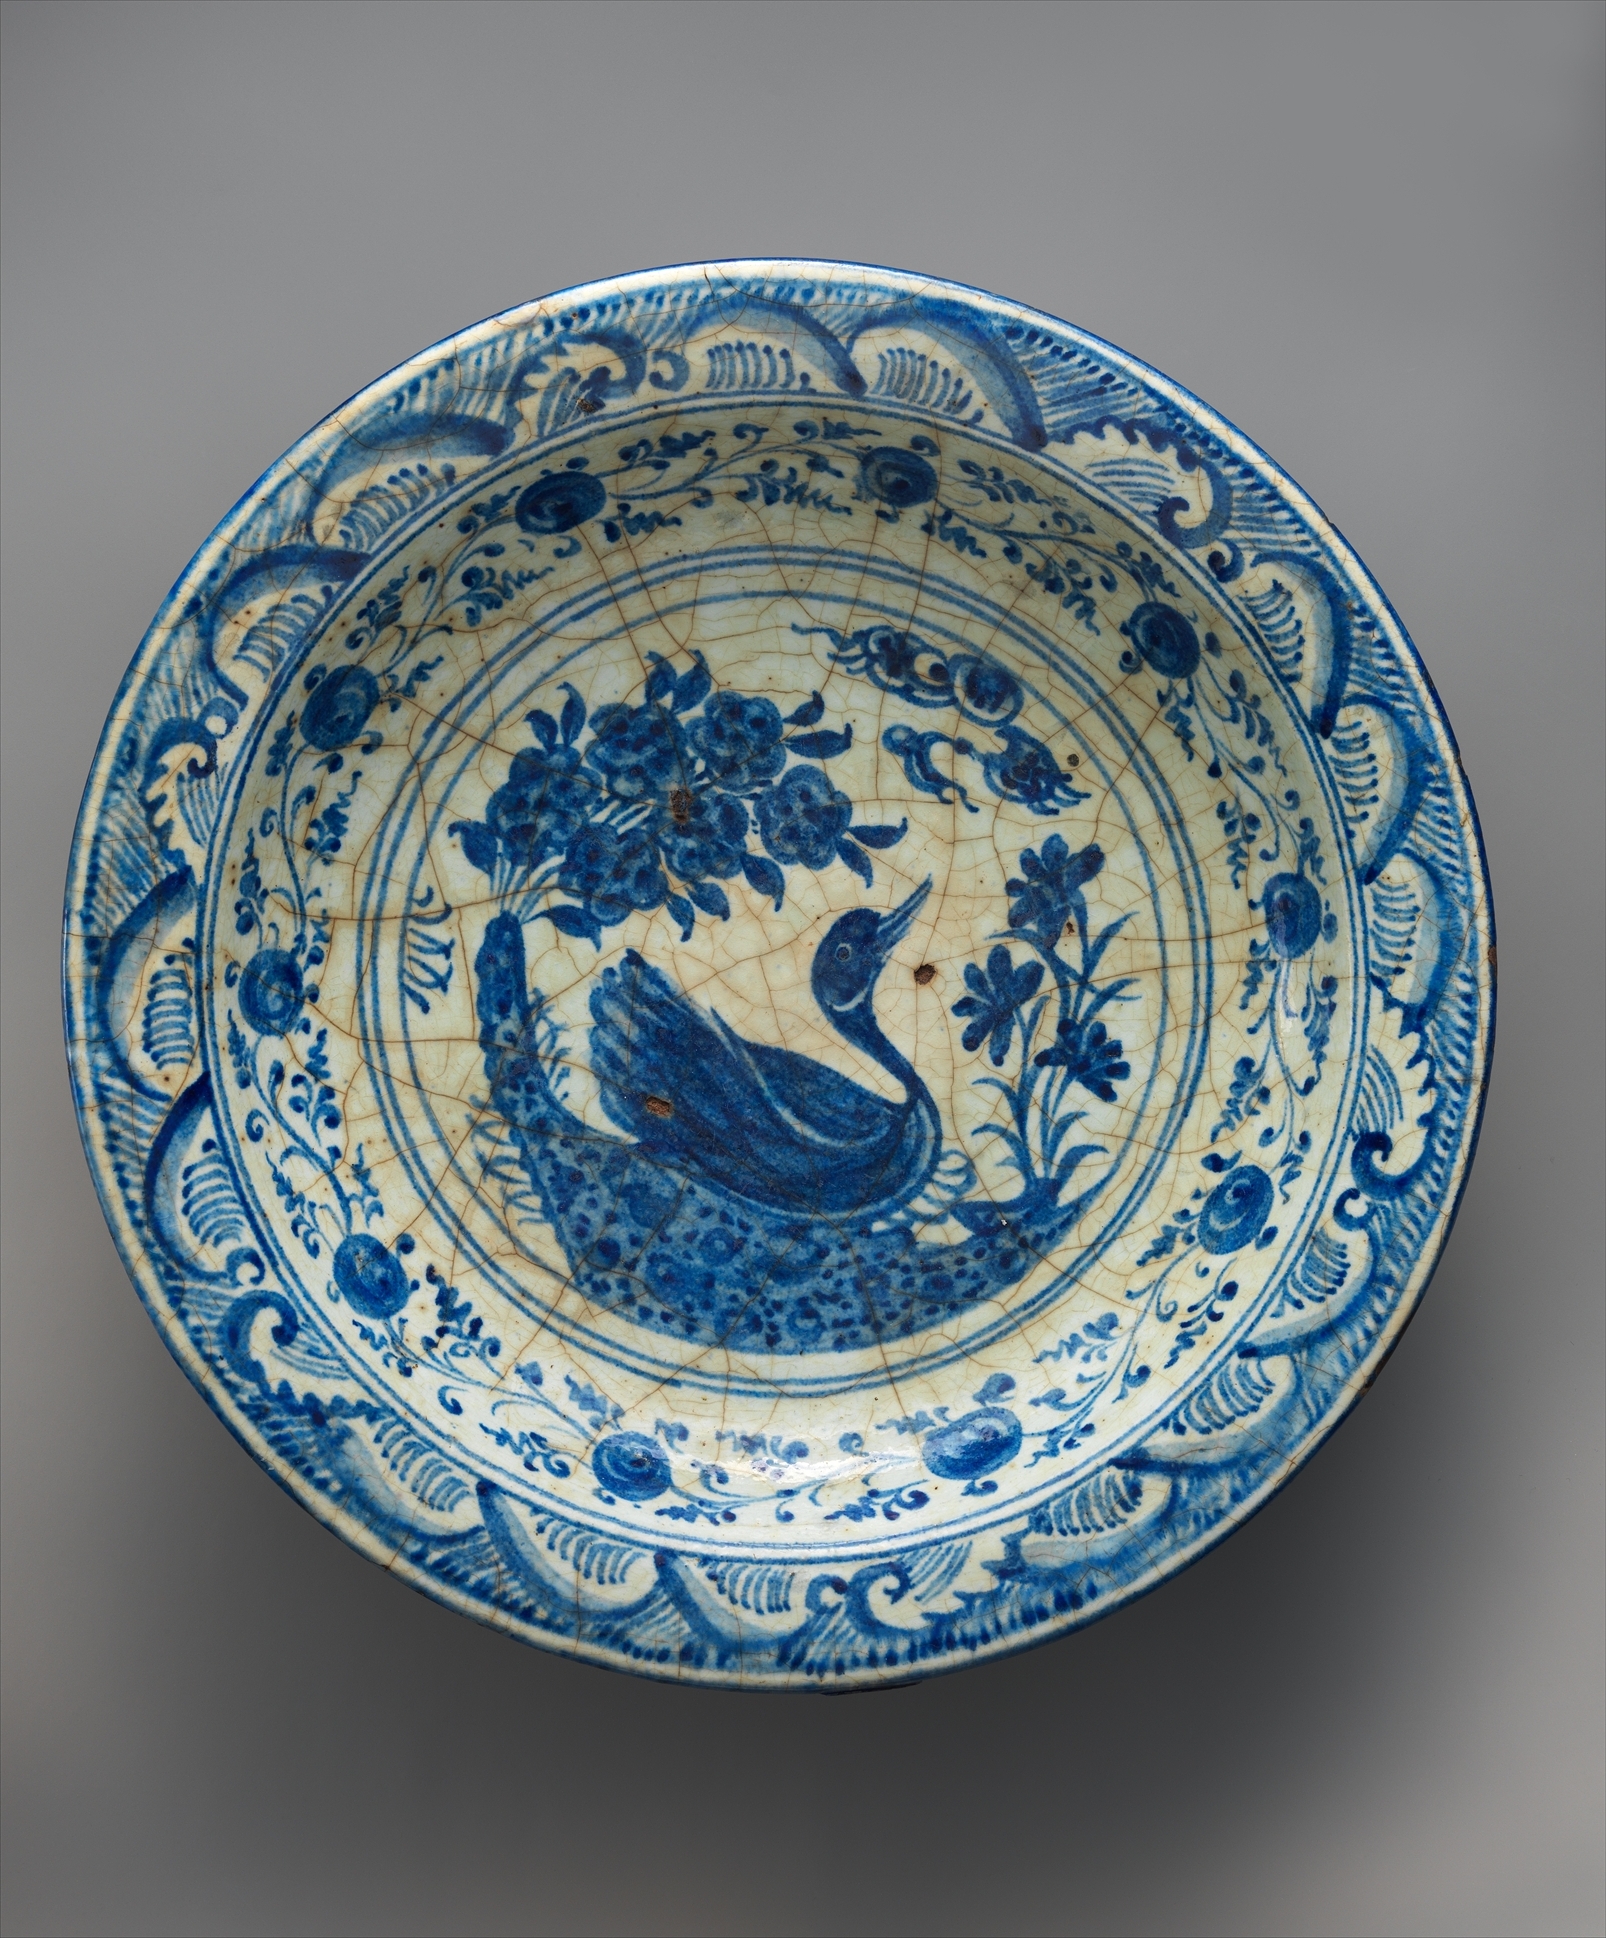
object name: dish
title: Dish with a Swimming Duck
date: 1501-1600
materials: glaze, stonepaste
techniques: painting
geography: iran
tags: ducks